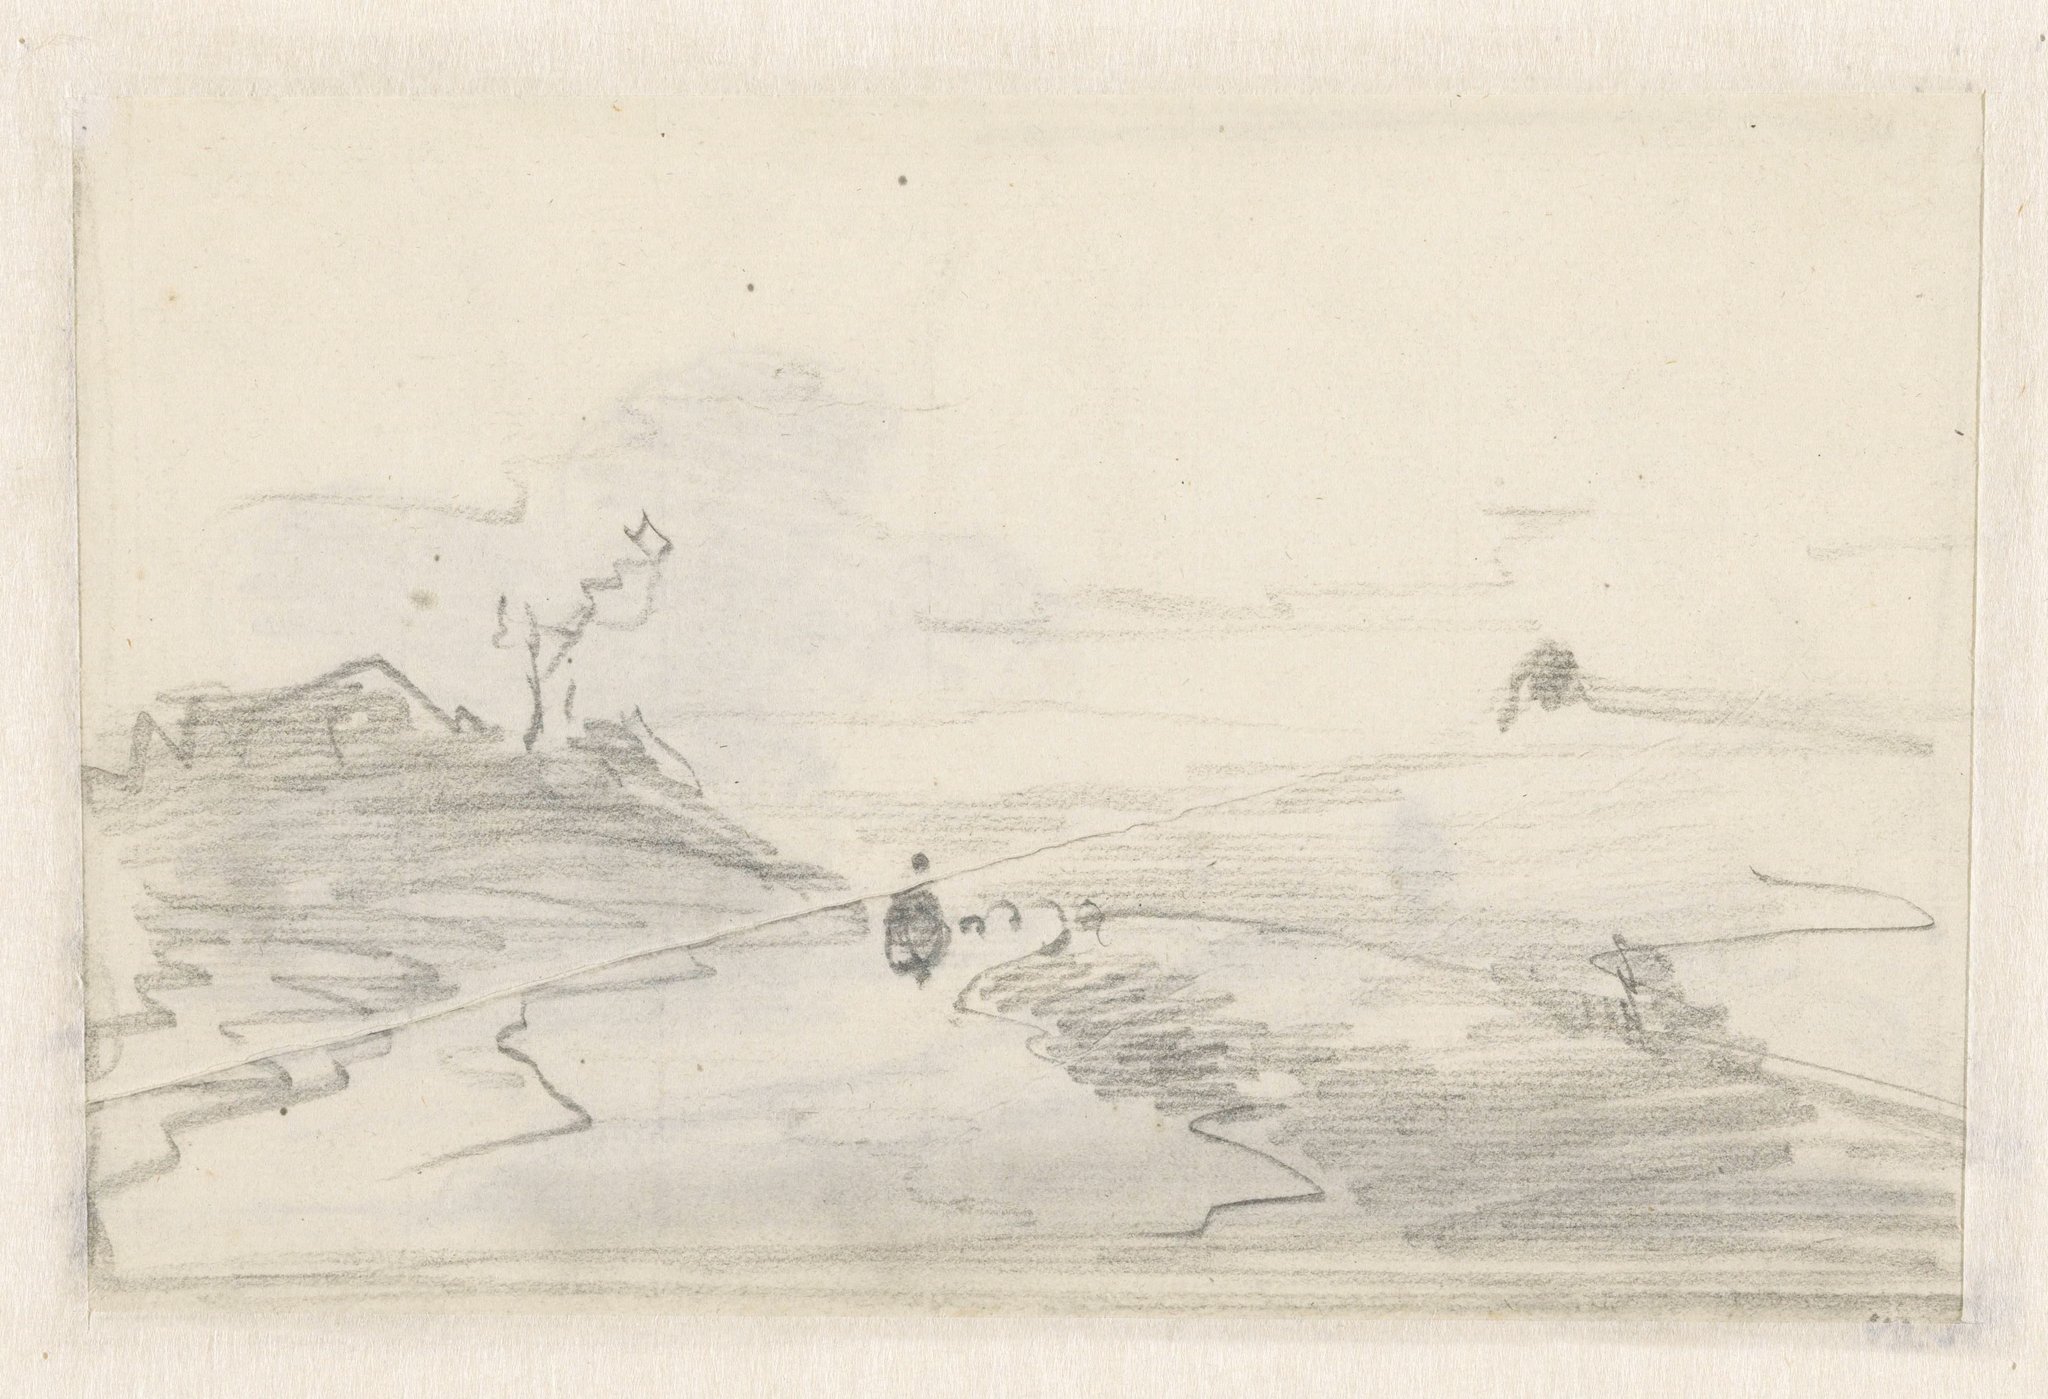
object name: drawing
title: Schets van een wandelaar op een weg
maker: andreas schelfhout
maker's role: draughtsman, painter, print maker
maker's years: 1787-1870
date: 1797-1870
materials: paper, pencil